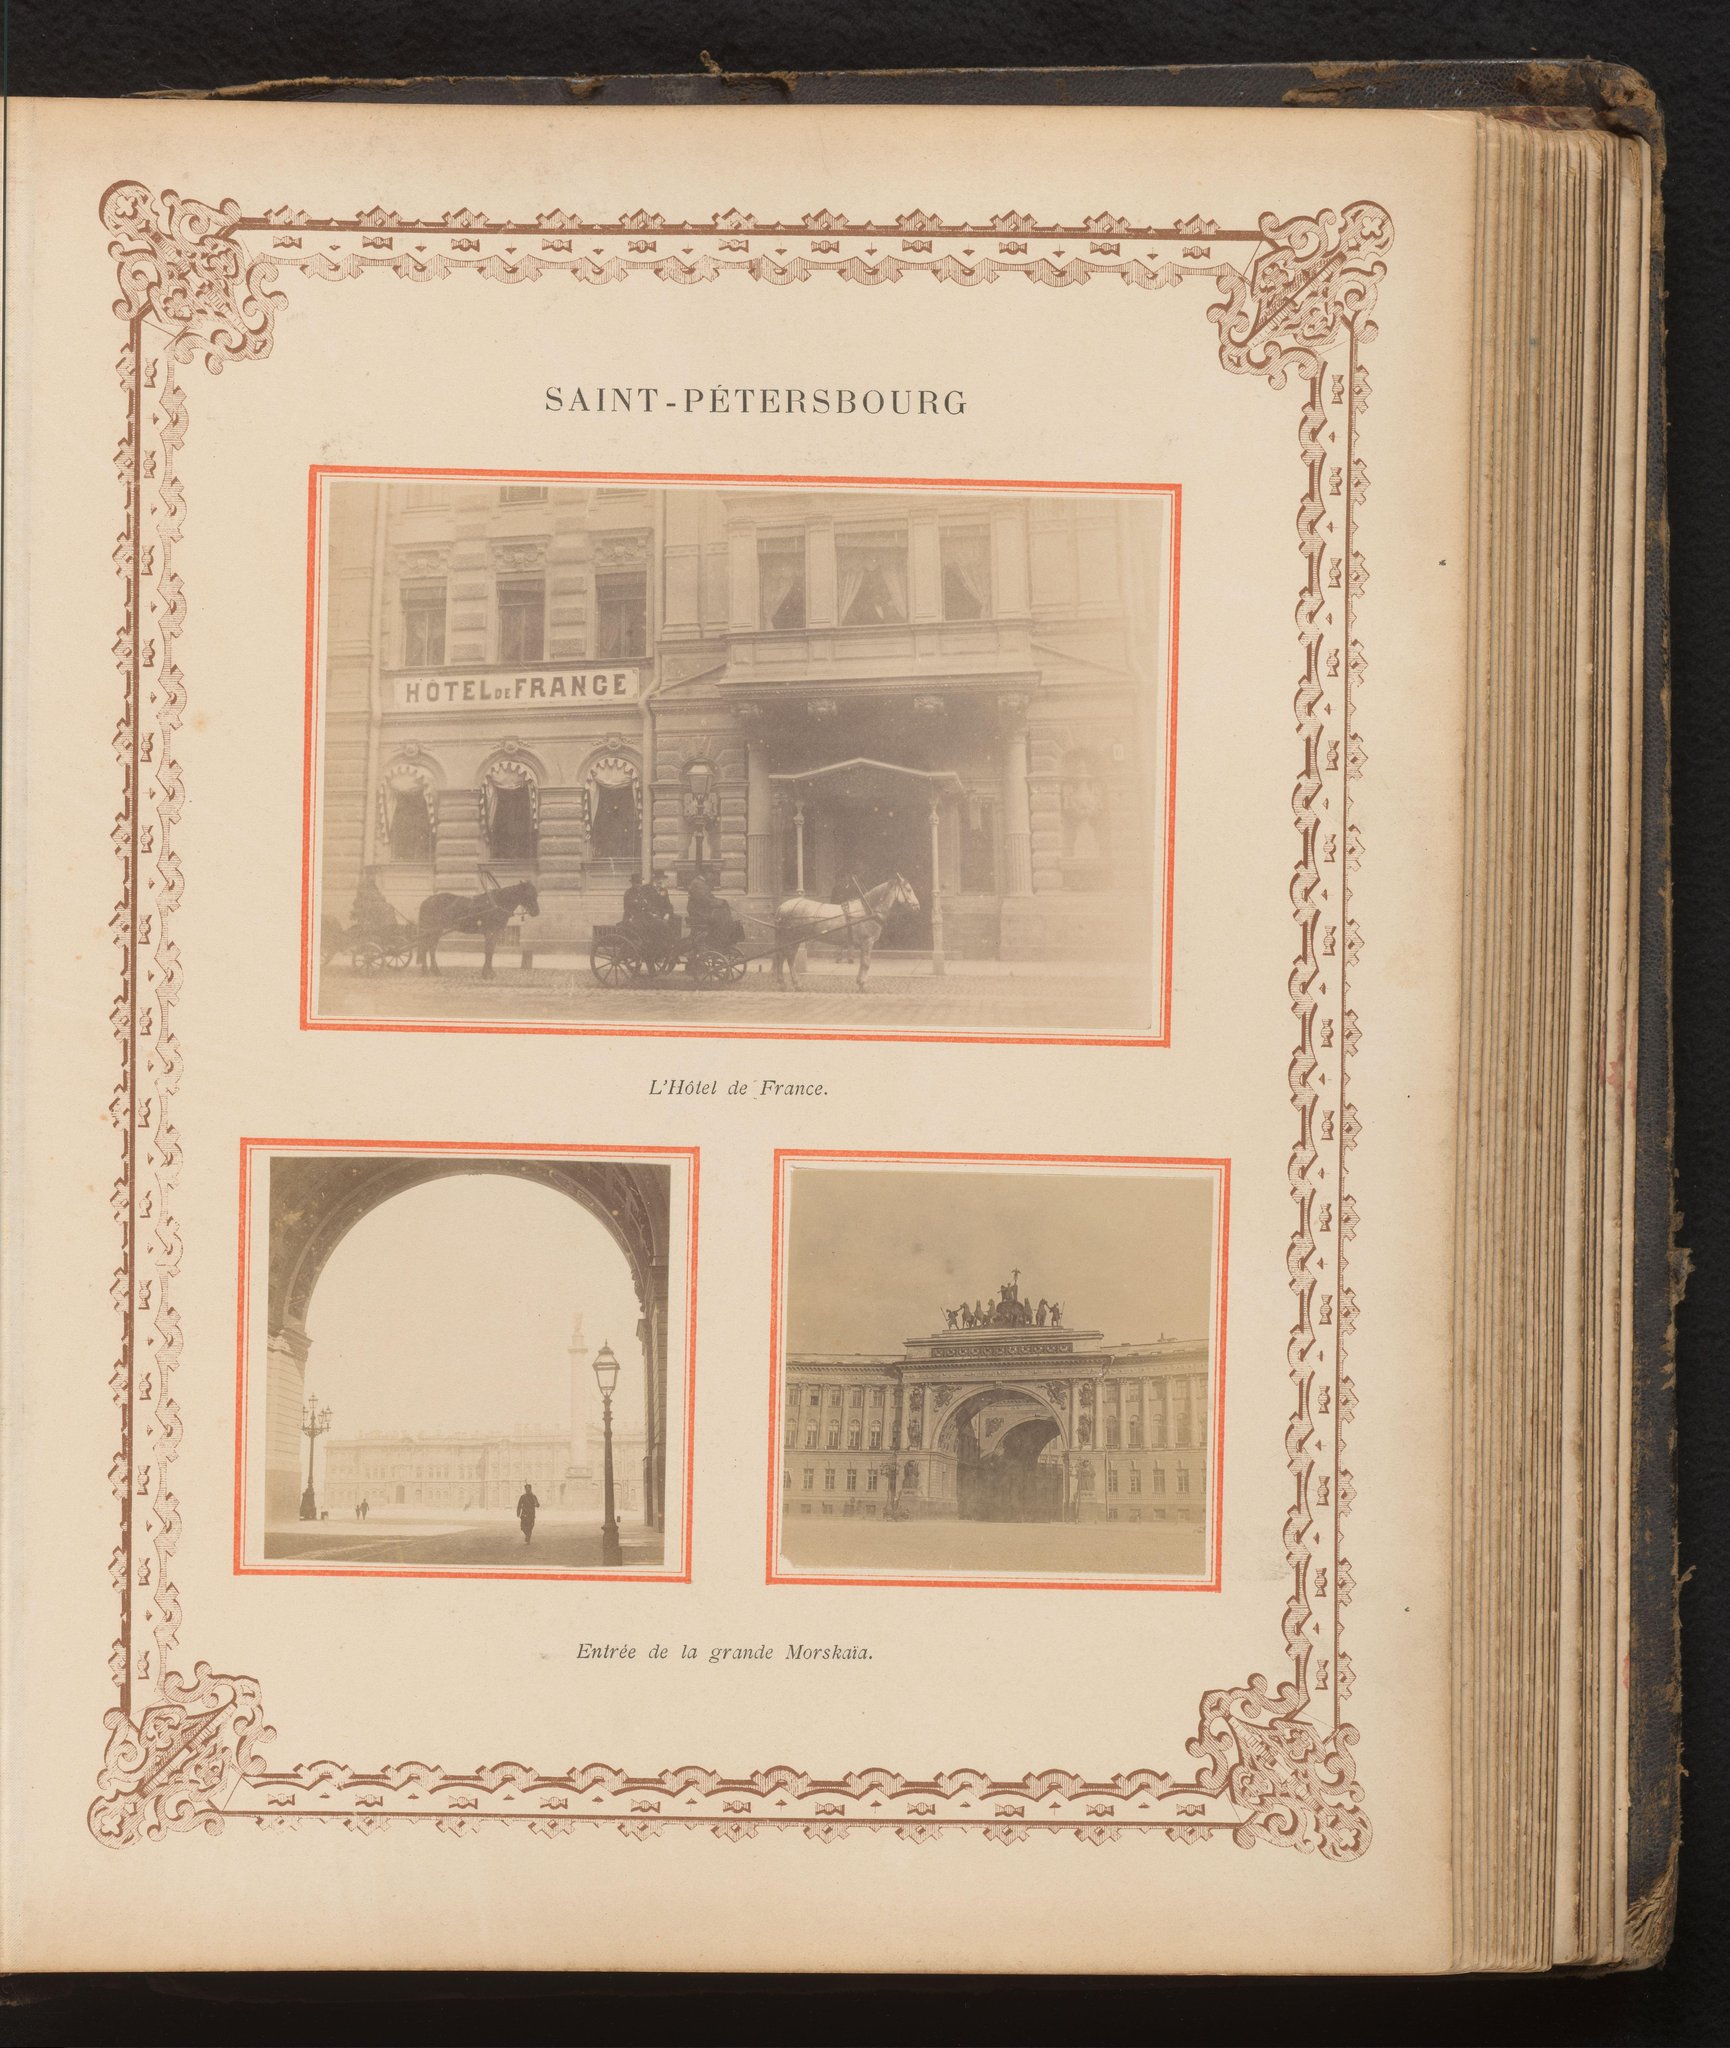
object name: photograph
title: L'Hôtel de France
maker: Anonymous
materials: photographic support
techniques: albumen print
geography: sint-petersburg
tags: triumphal arch, hotel, hostelry, inn